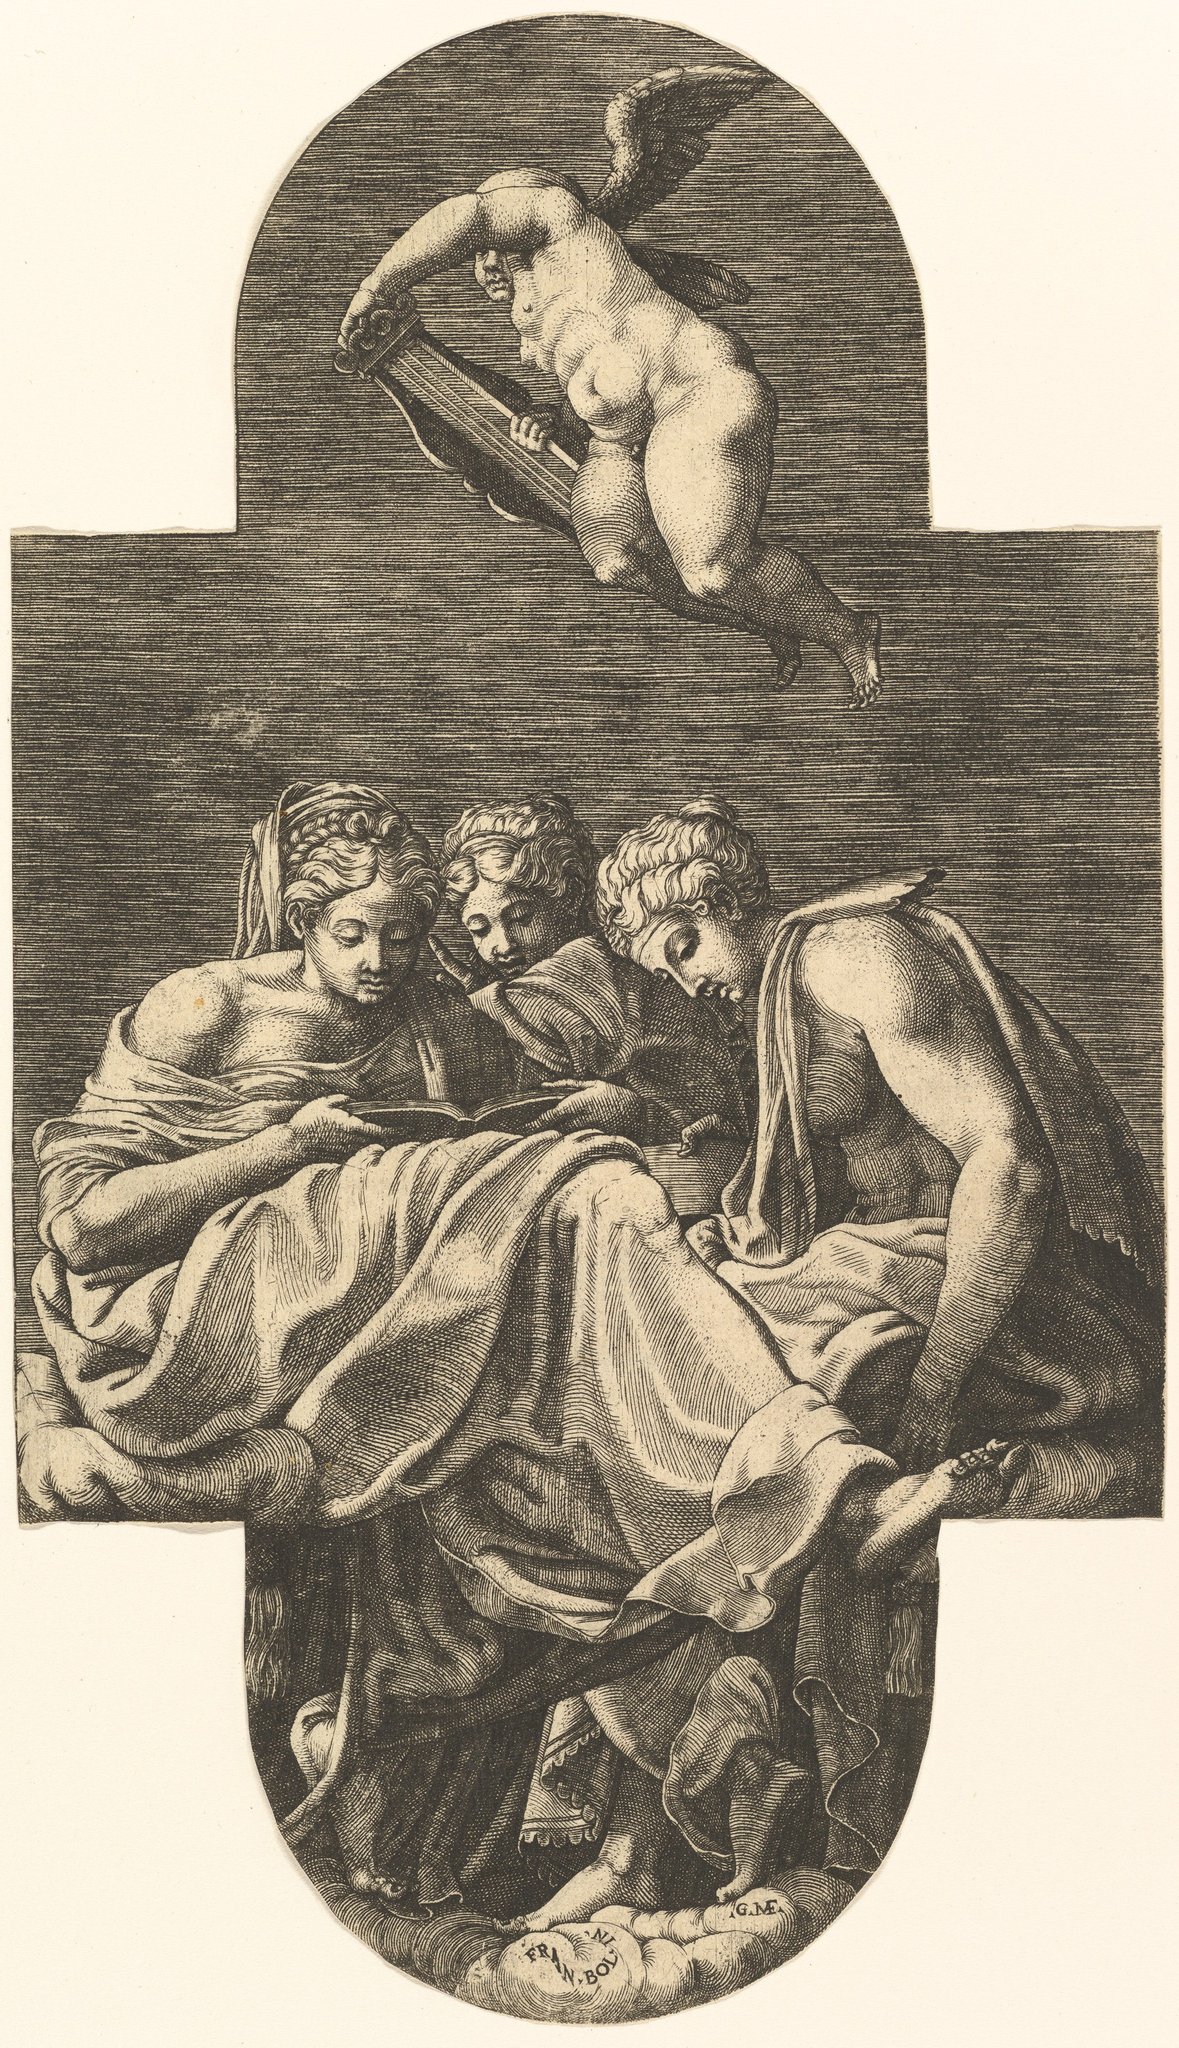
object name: print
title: Three Muses and a putto above with a lyre, from a series of eight compositions after Francesco Primaticcio's designs for the ceiling of the Ulysses Gallery (destroyed 1738-39) at Fontainebleau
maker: giorgio ghisi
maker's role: artist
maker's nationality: italian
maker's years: 1515-1582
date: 1560-1569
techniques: engraving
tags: musical instruments,muses